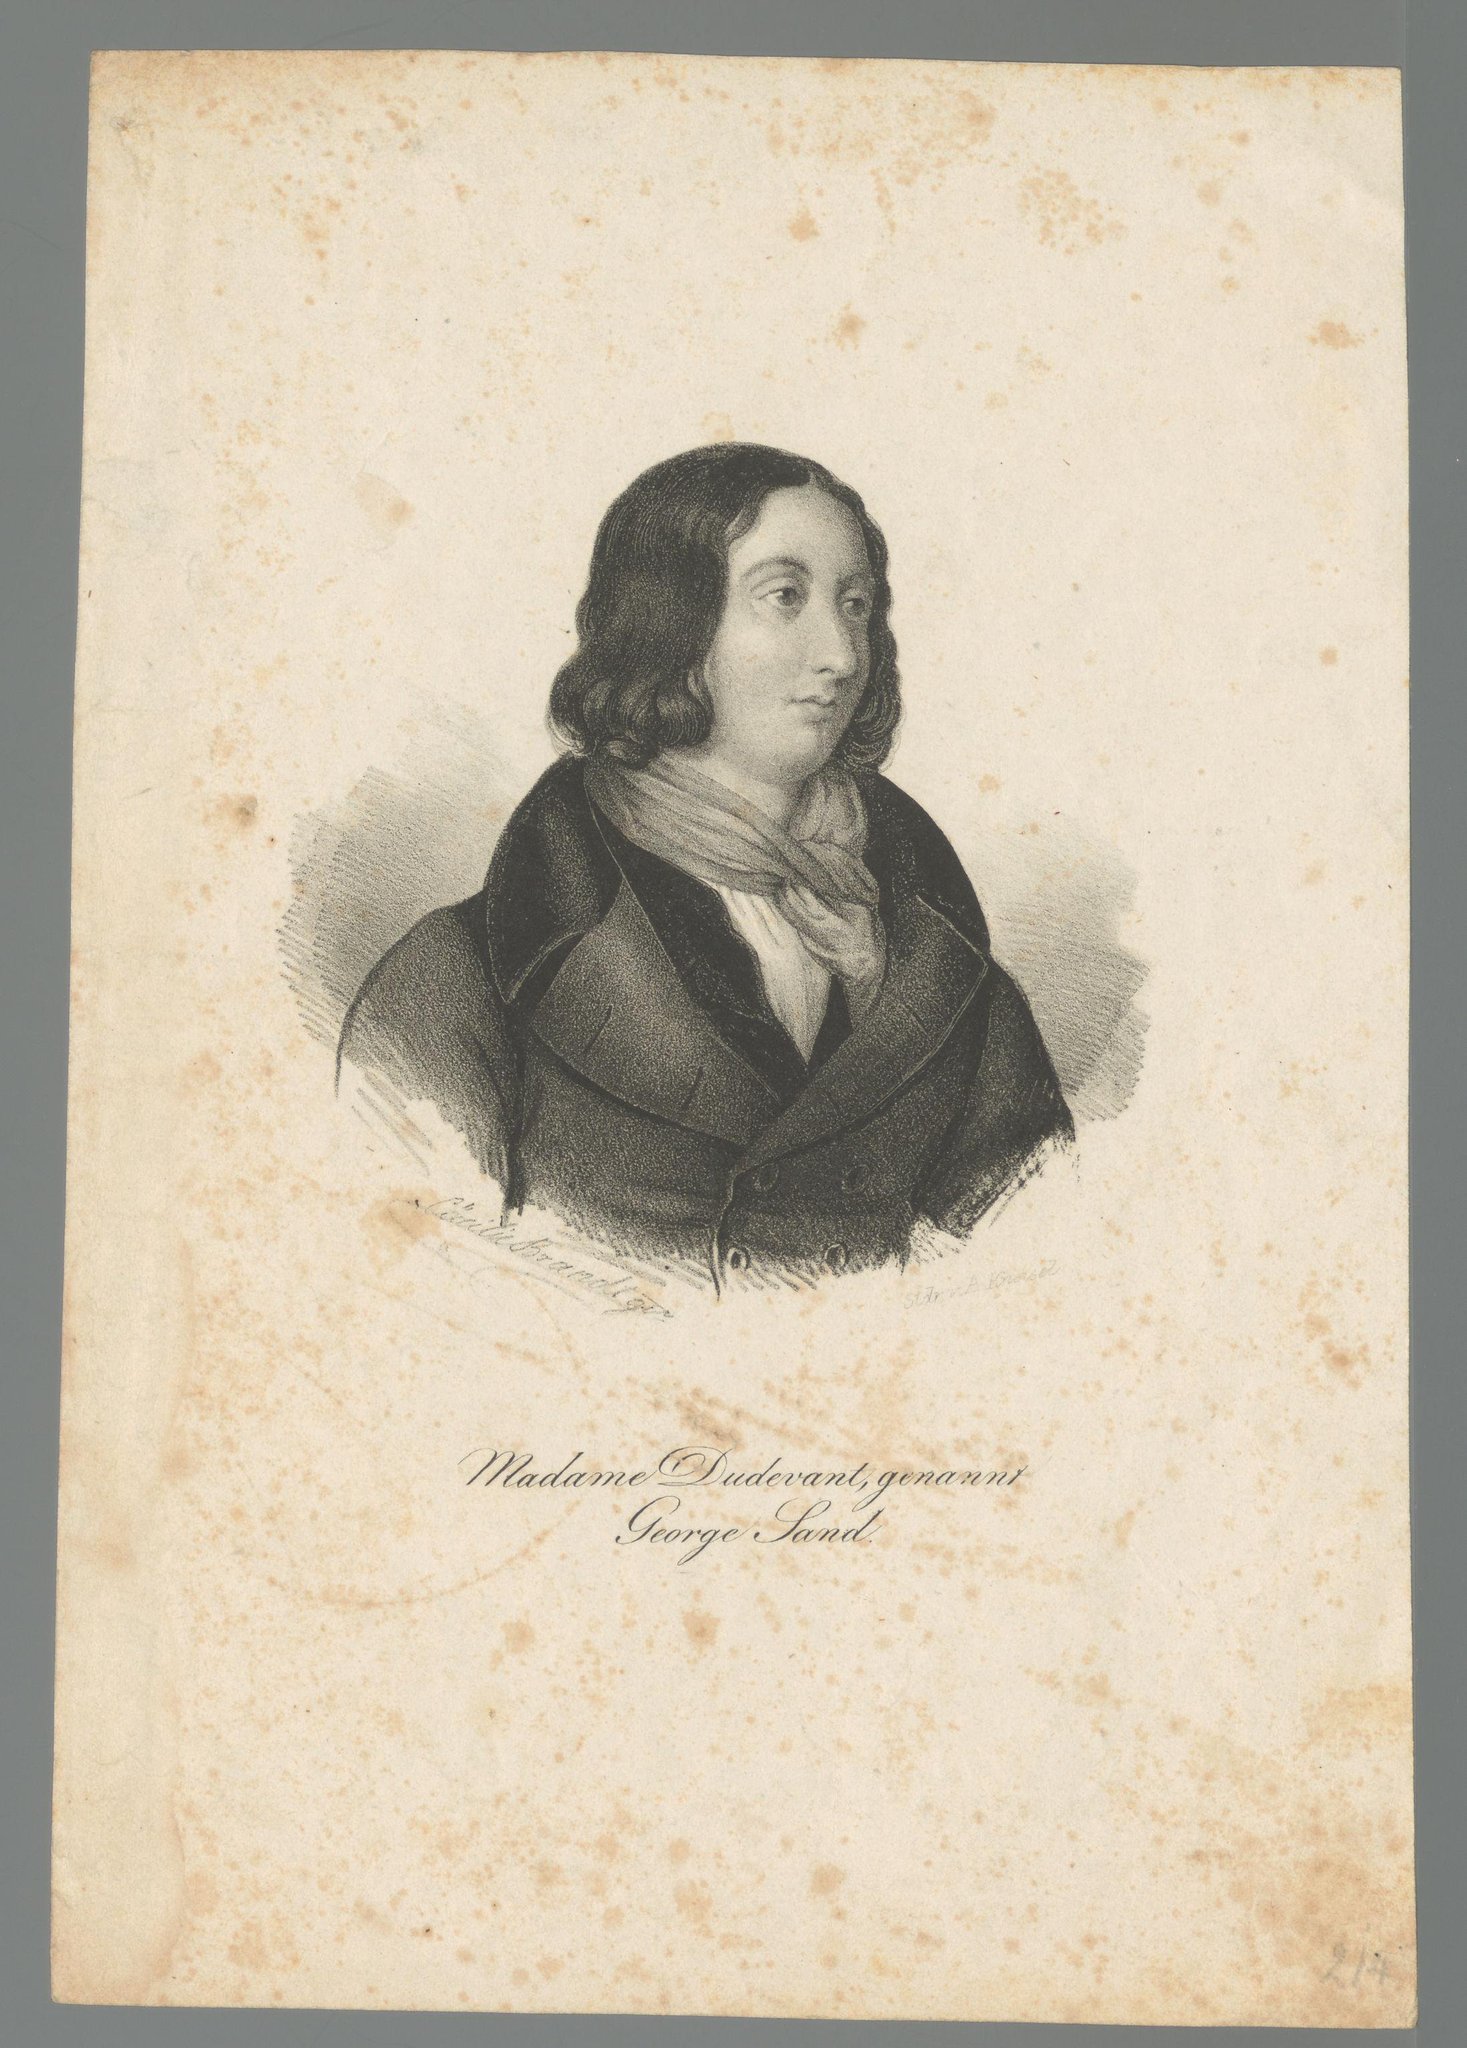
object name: print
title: Madame Dudevant, genannt George Sand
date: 1829-1839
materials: paper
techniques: lithograph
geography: leipzig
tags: paris, george sand, adult woman, historical persons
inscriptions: inscription: ‘Portr. 61475/ Dudevant. LB XXIV 445729’, collector's mark: Lugt 2760, collector's mark: Lugt 2228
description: De schrijfster George Sand (1804-1876) in mannenkostuum. Buste naar rechts.